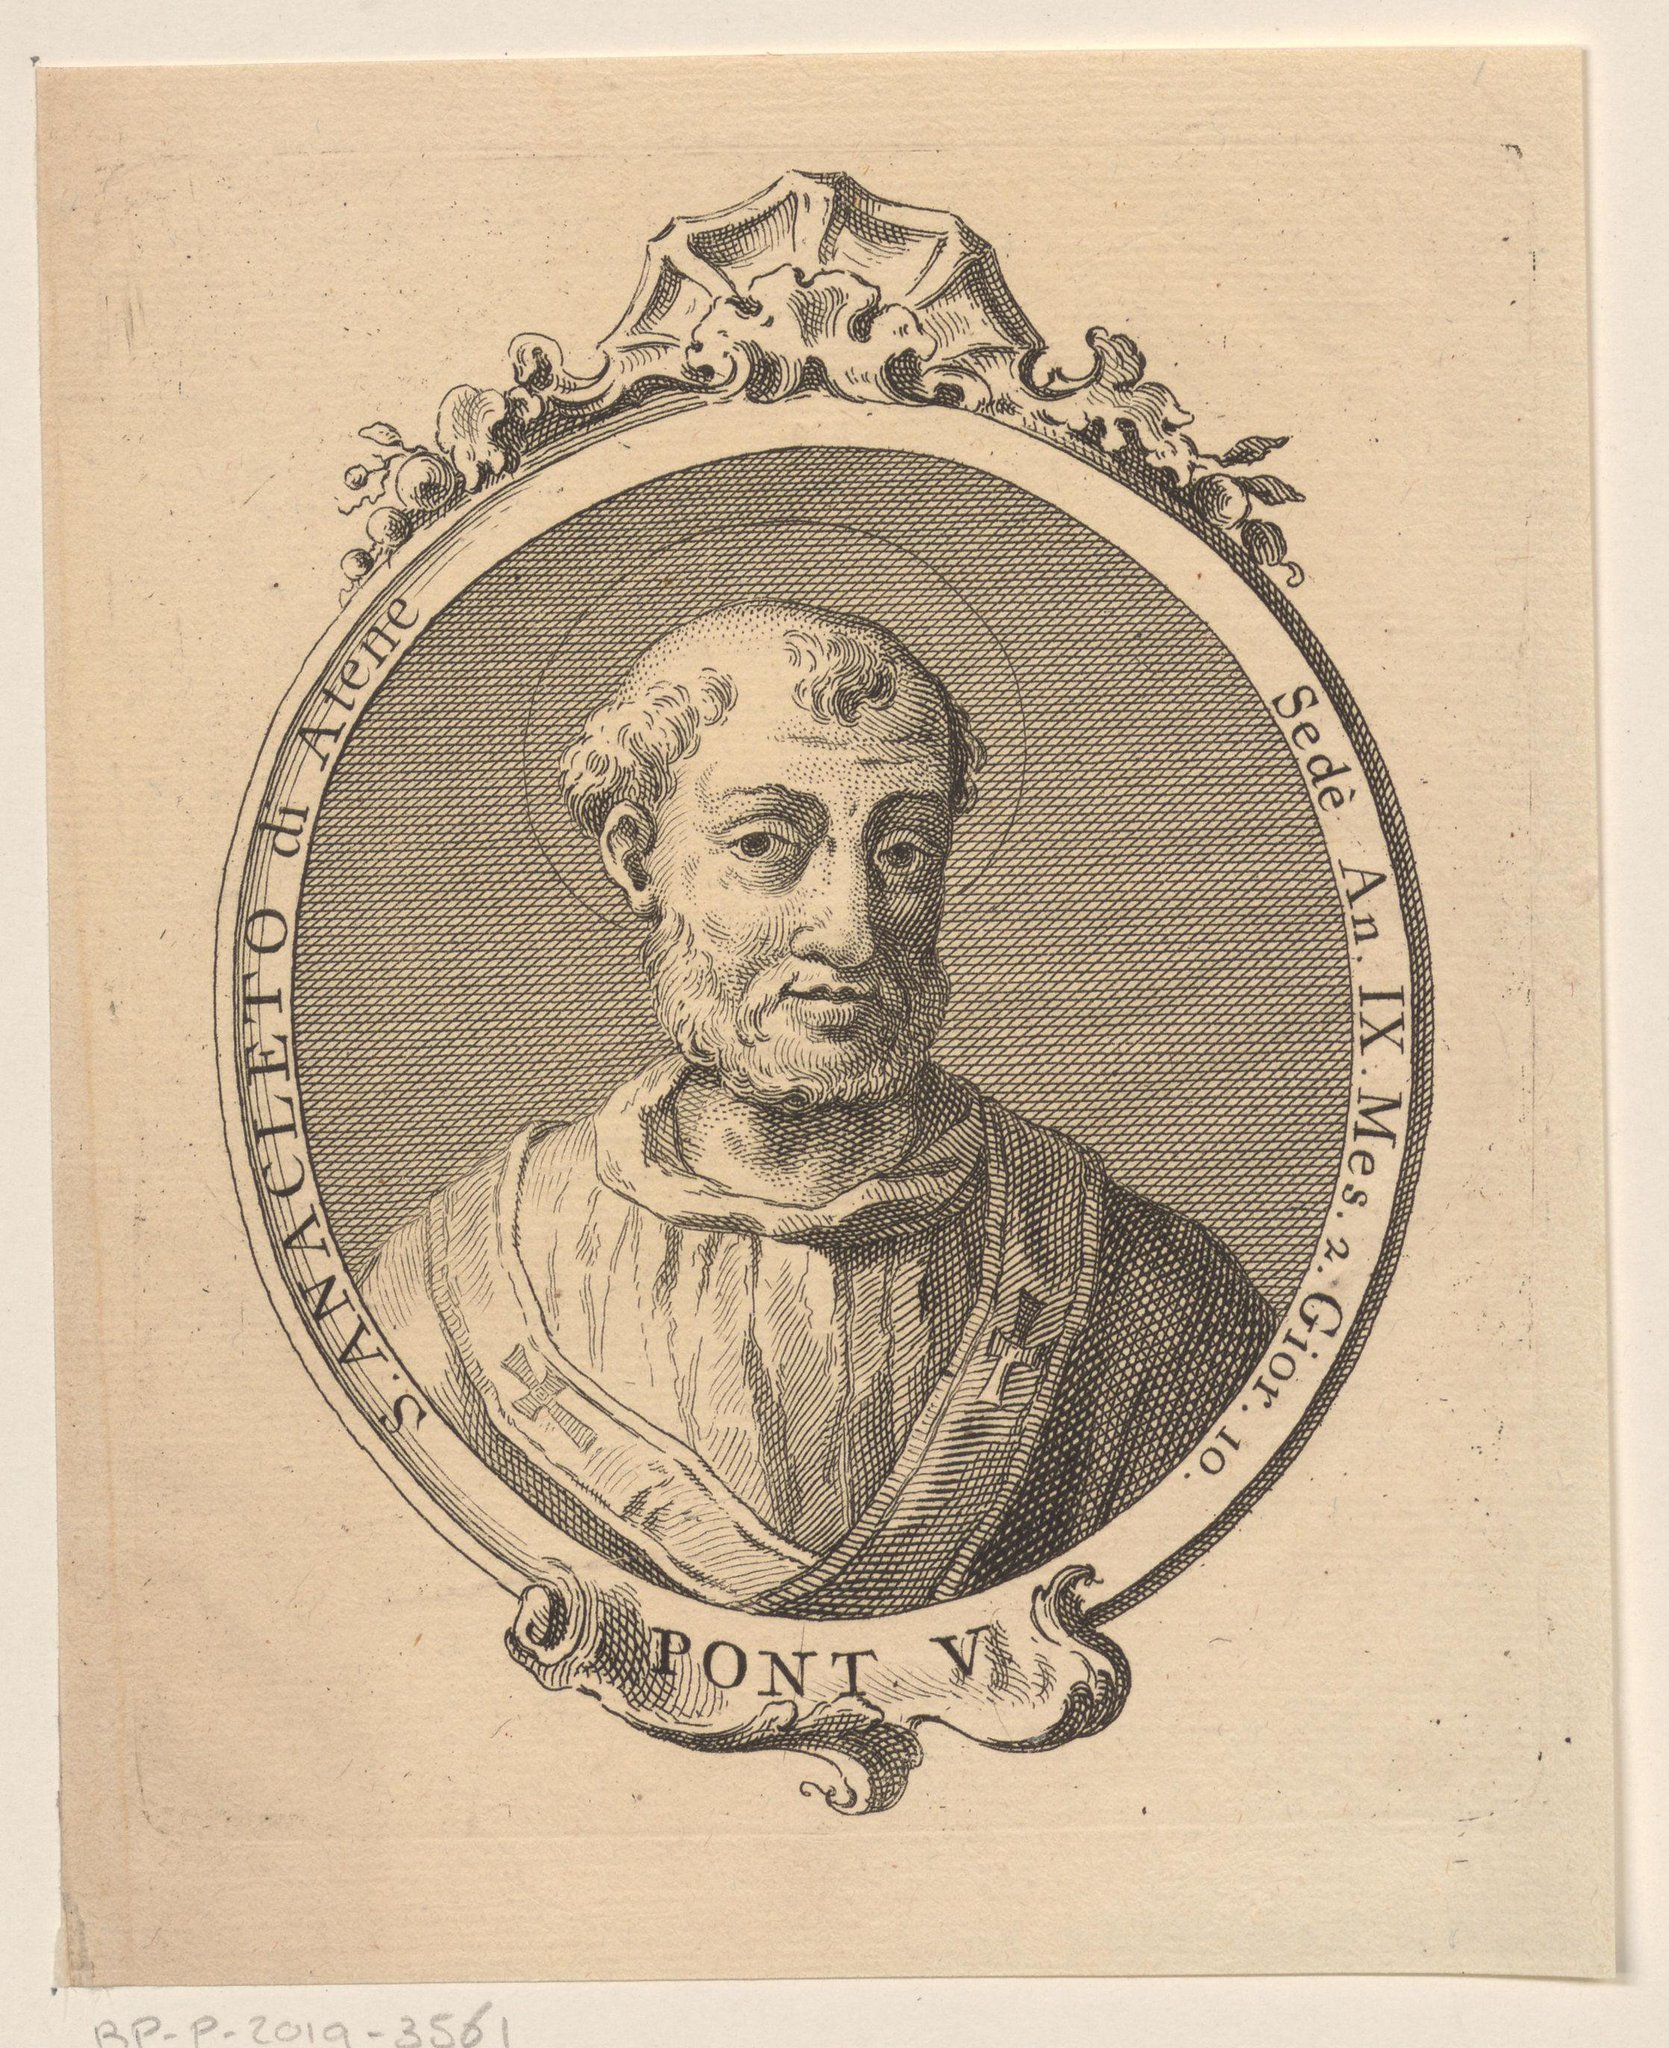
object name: book illustration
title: Portret van paus Anacletus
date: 1775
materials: paper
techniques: etching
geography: bassano del grappa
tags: rome, priest, historical persons, pope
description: Prent uit: Effigies Romanorum pontificum a S. Petro ad Pium VI. feliciter regnantem (...). 2 dln. Venetië en Bassano del Grappa: Giuseppe Remondini, 1775.